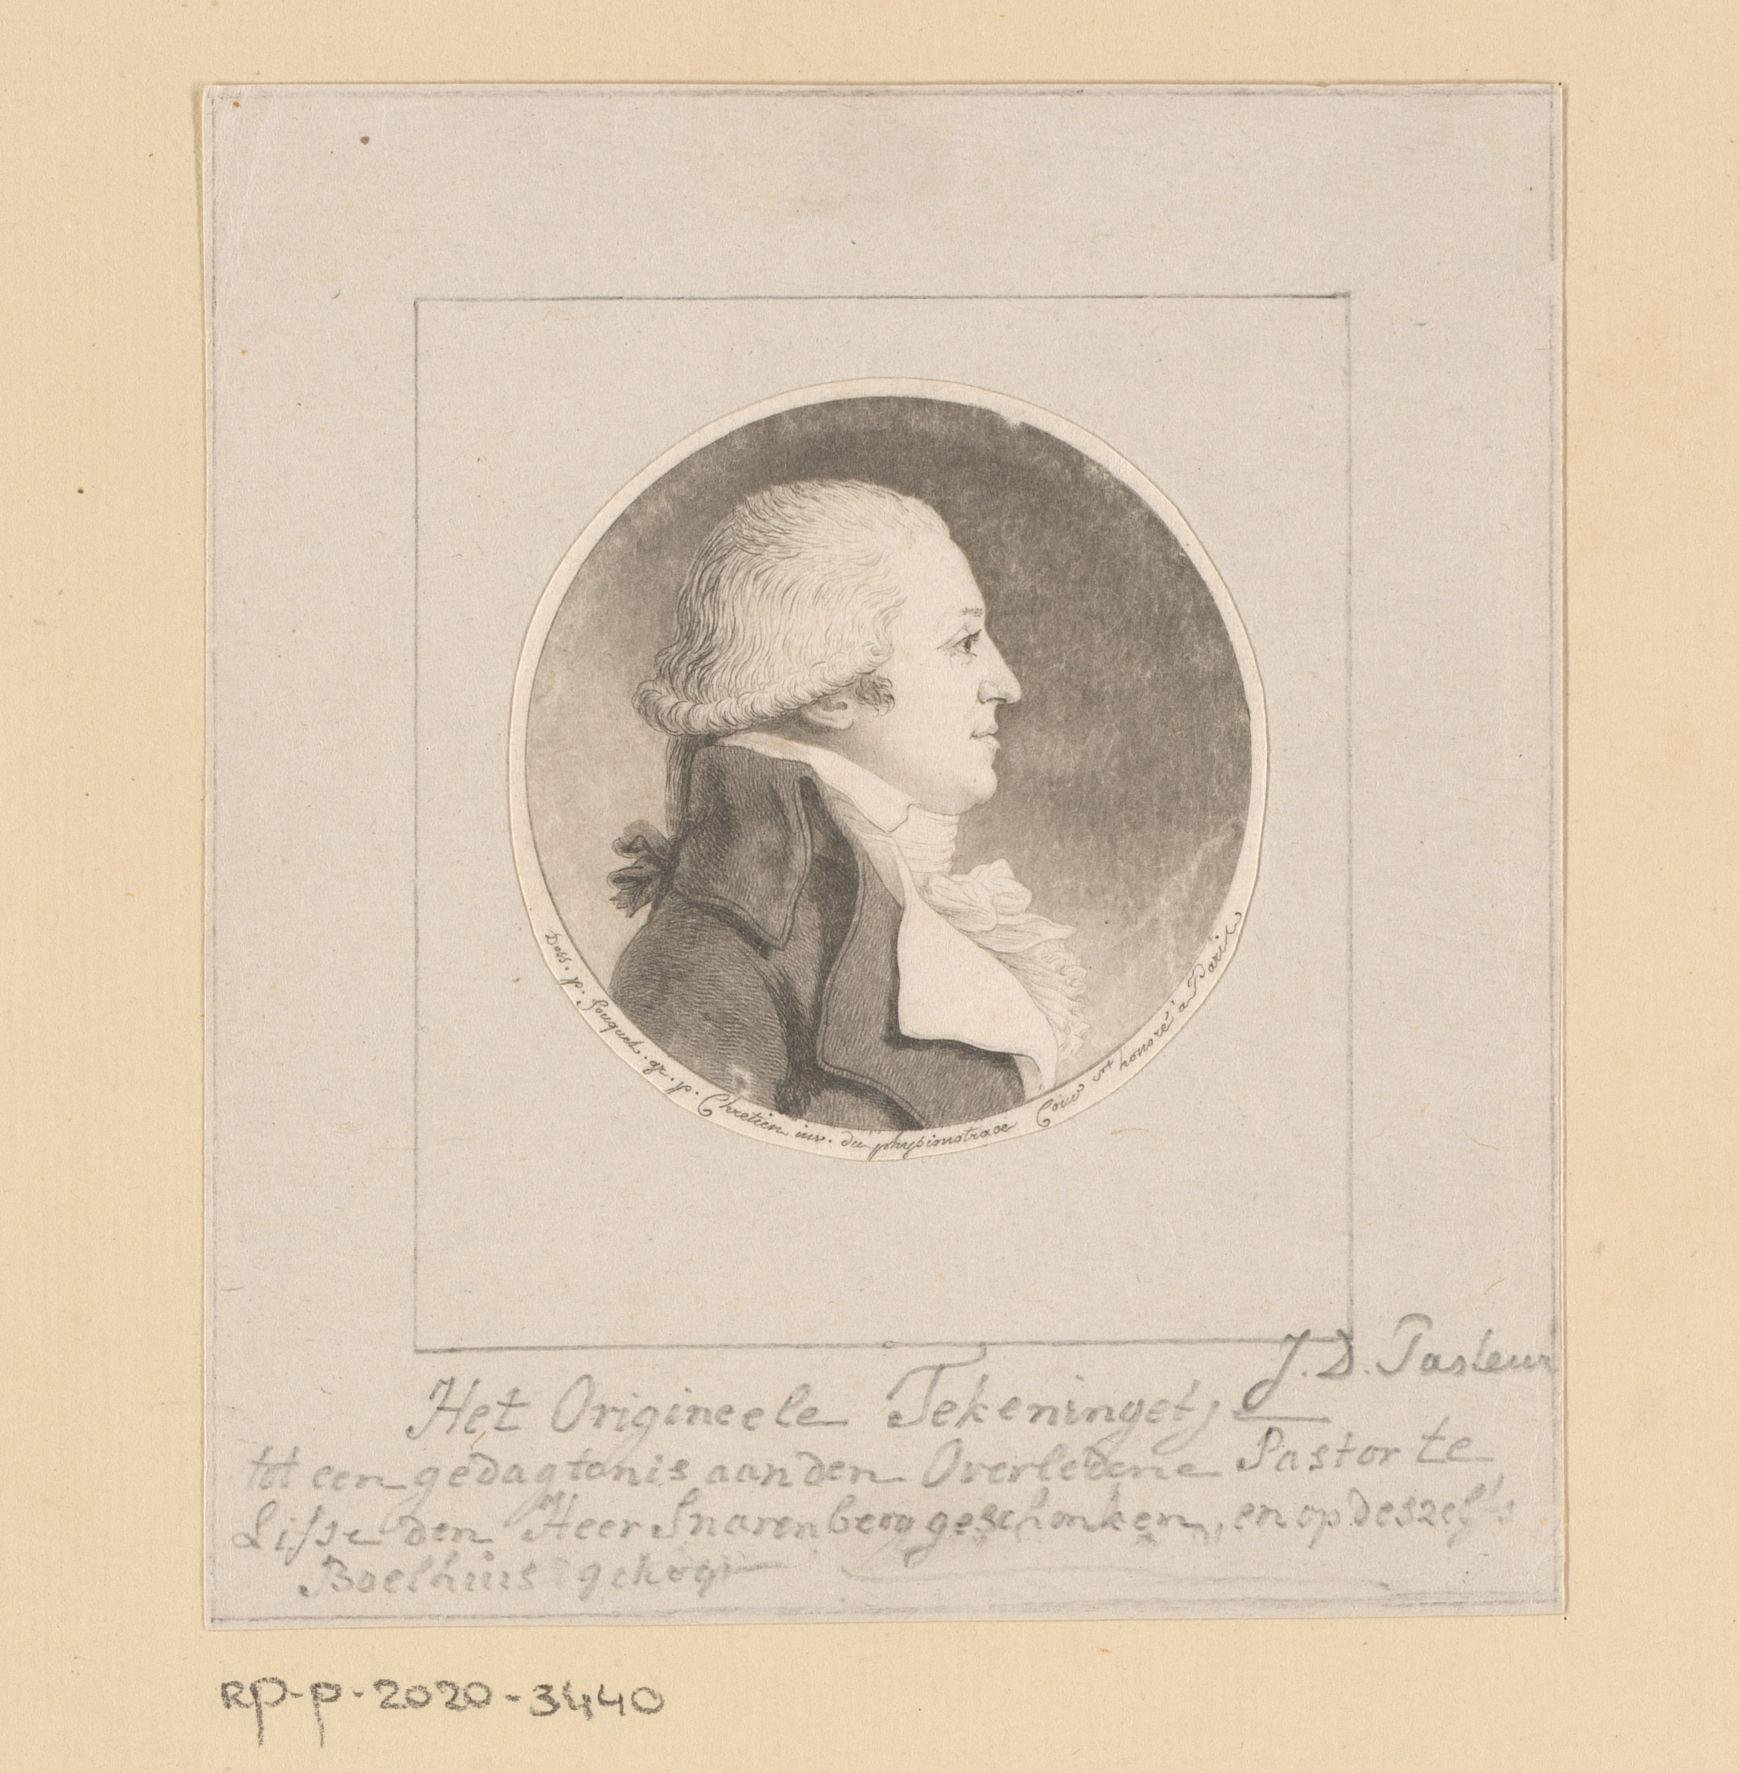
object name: print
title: Portret van Stefanus Jacobus van Langen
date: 1785-1811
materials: paper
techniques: aquatint, etching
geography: paris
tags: silhouette-apparatus, 'physionotrace', historical persons